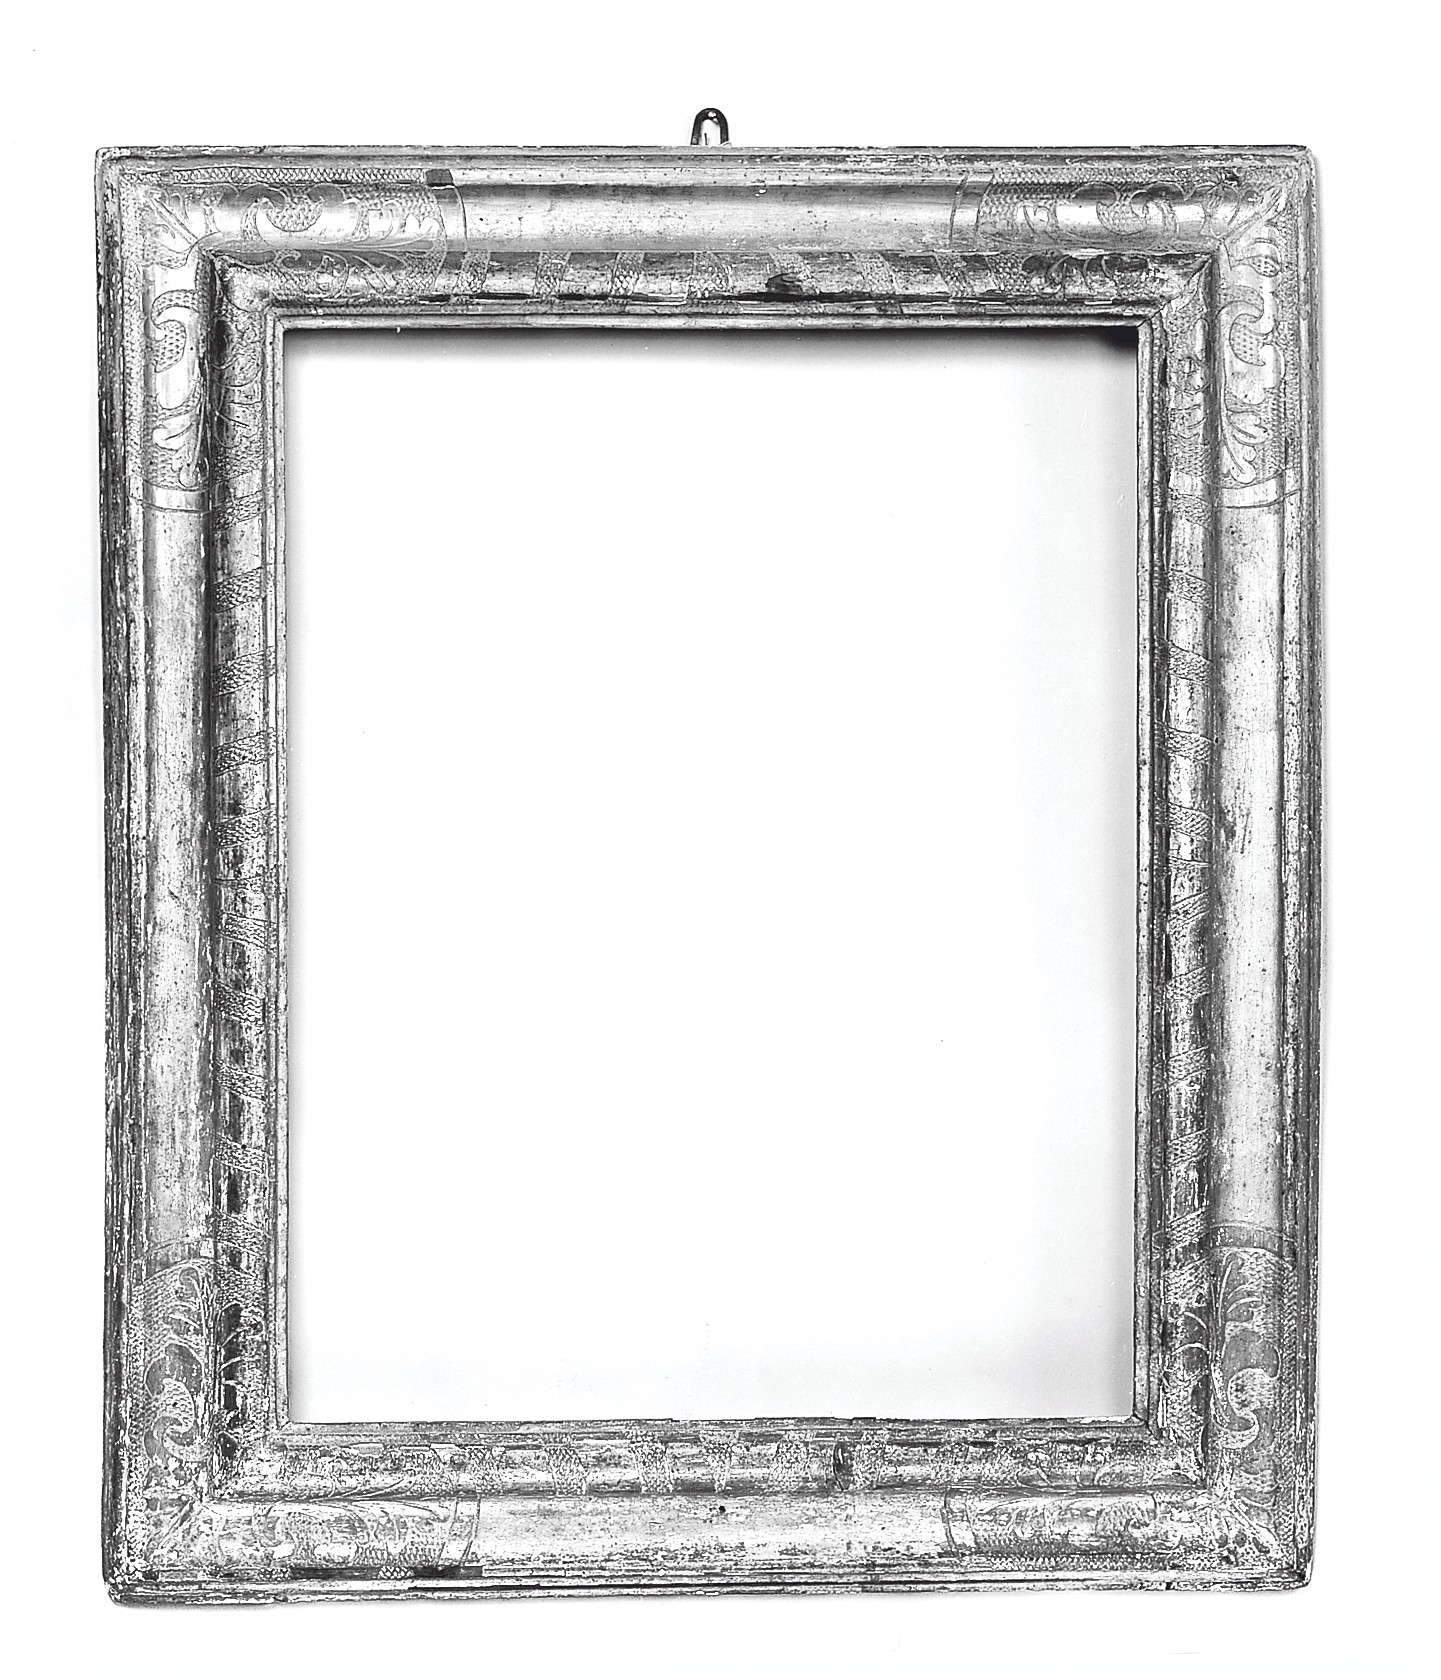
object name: frame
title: Reverse corner frame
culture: southern italian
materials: wood